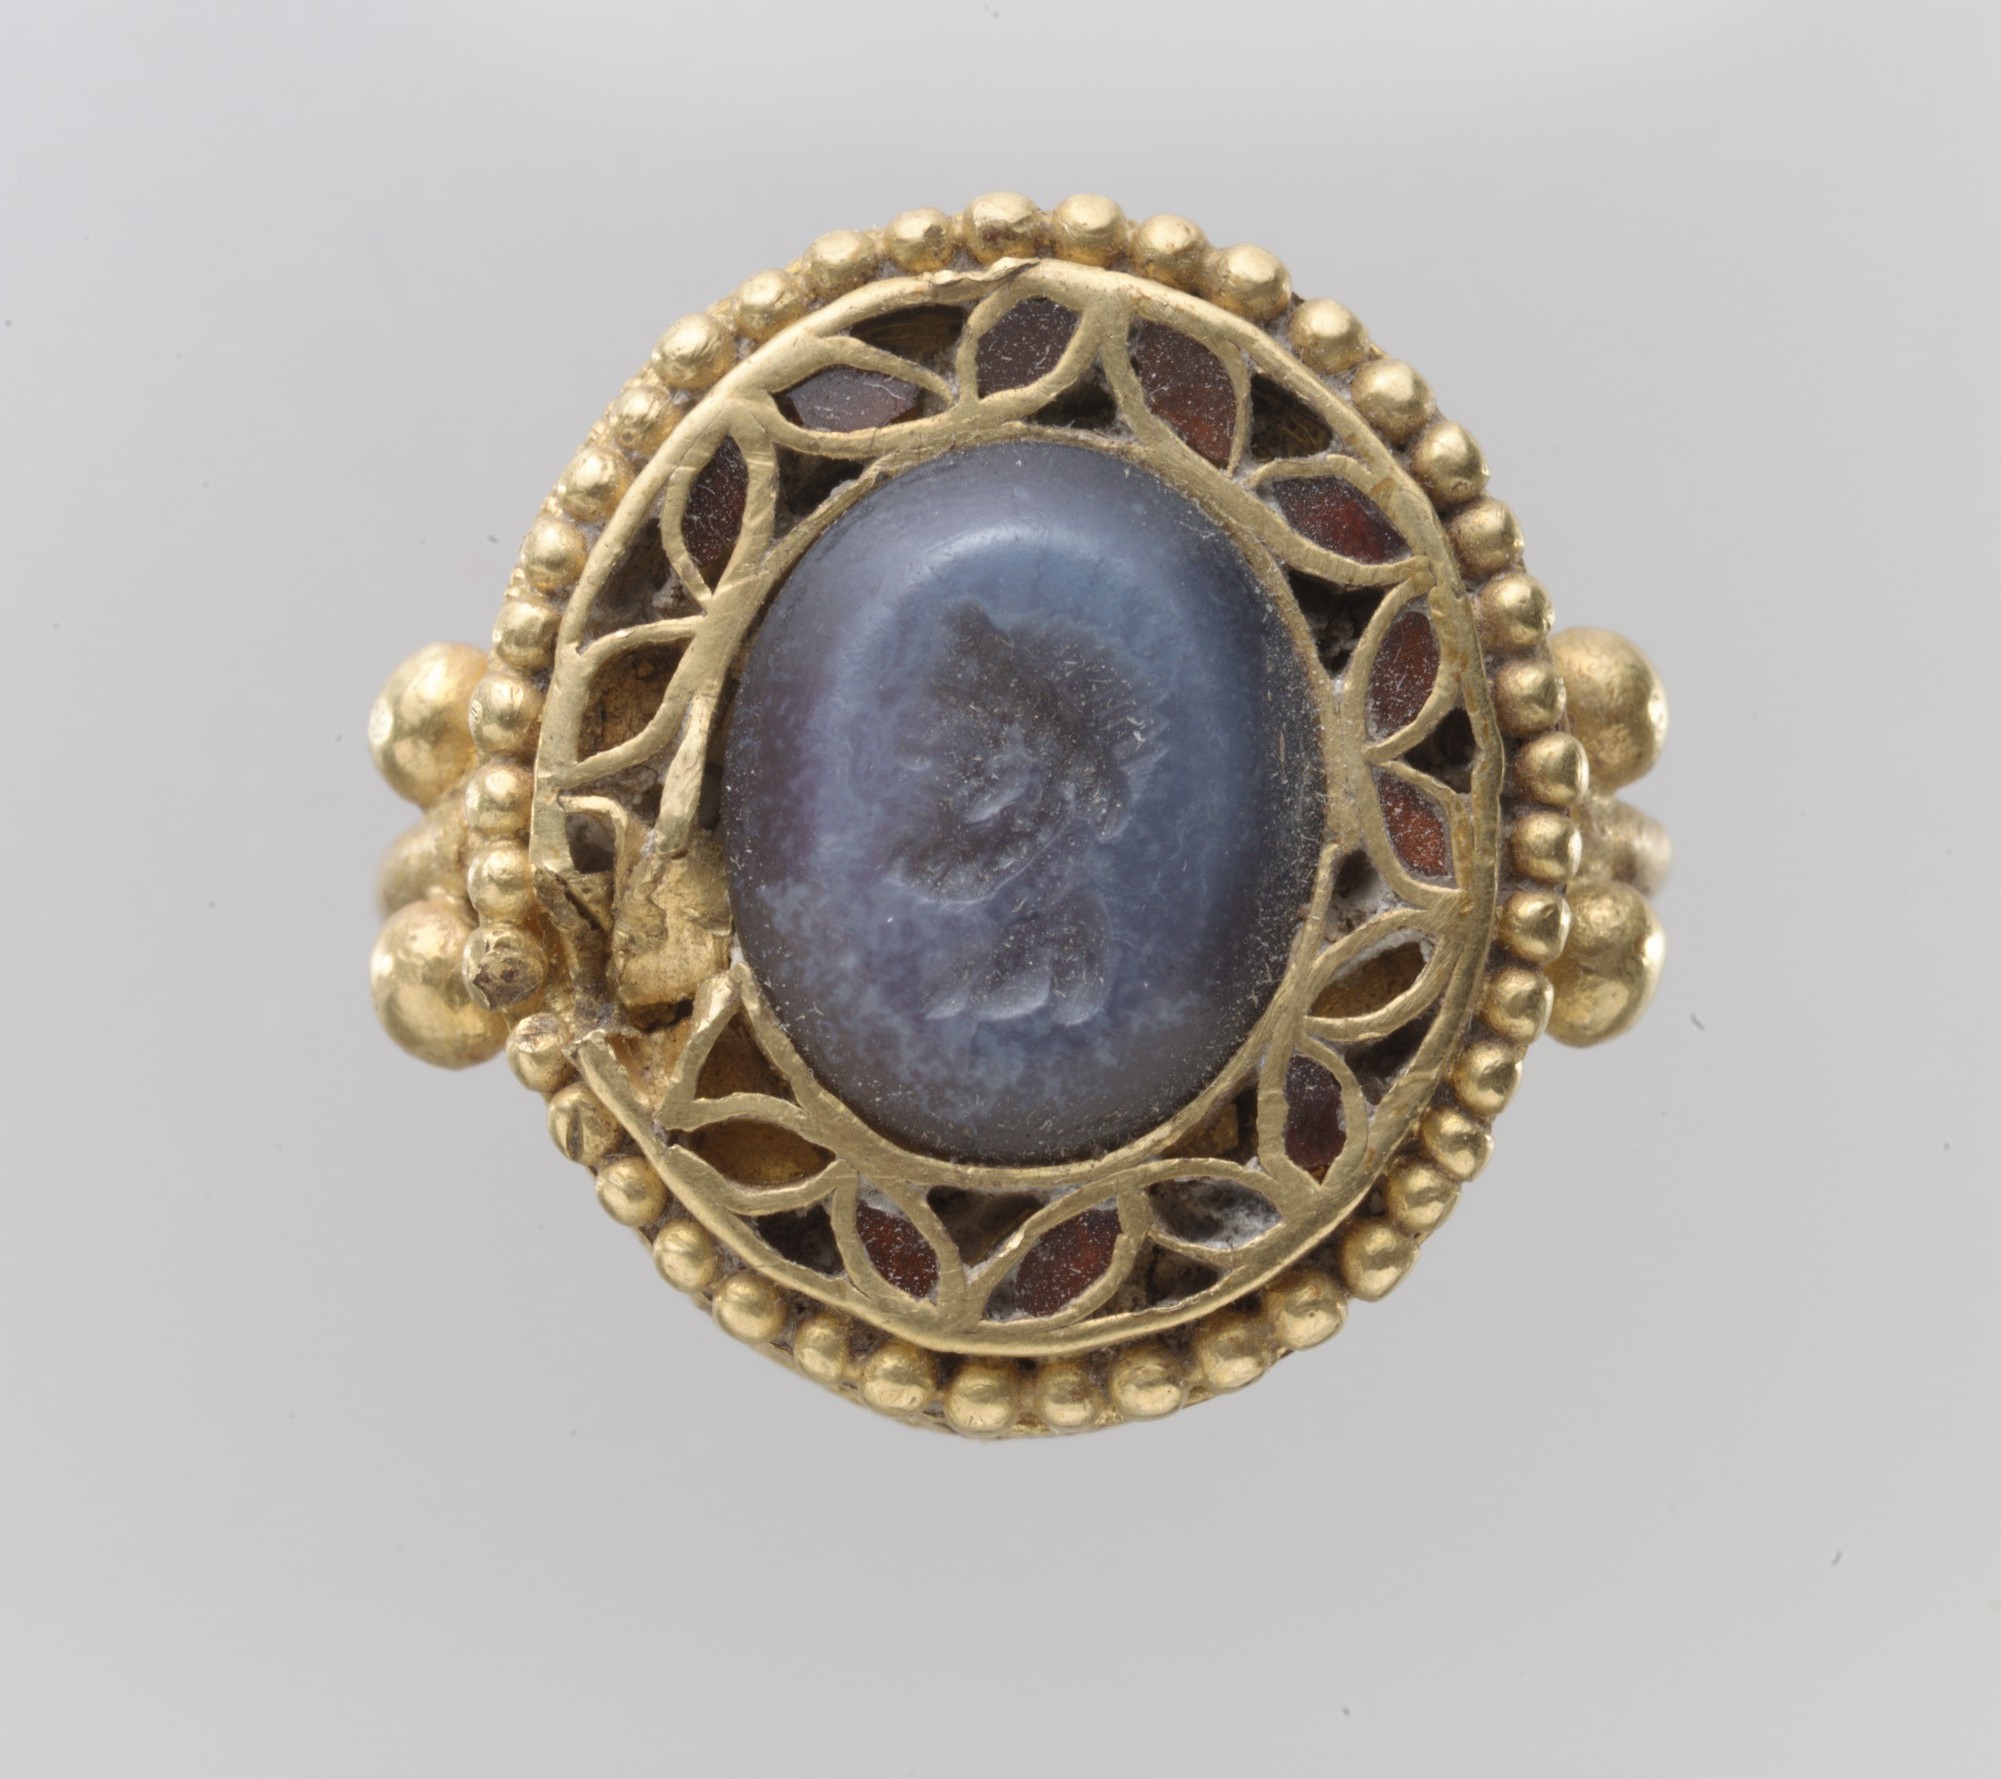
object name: intaglio in ring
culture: langobardic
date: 601-700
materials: stone, gold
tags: men